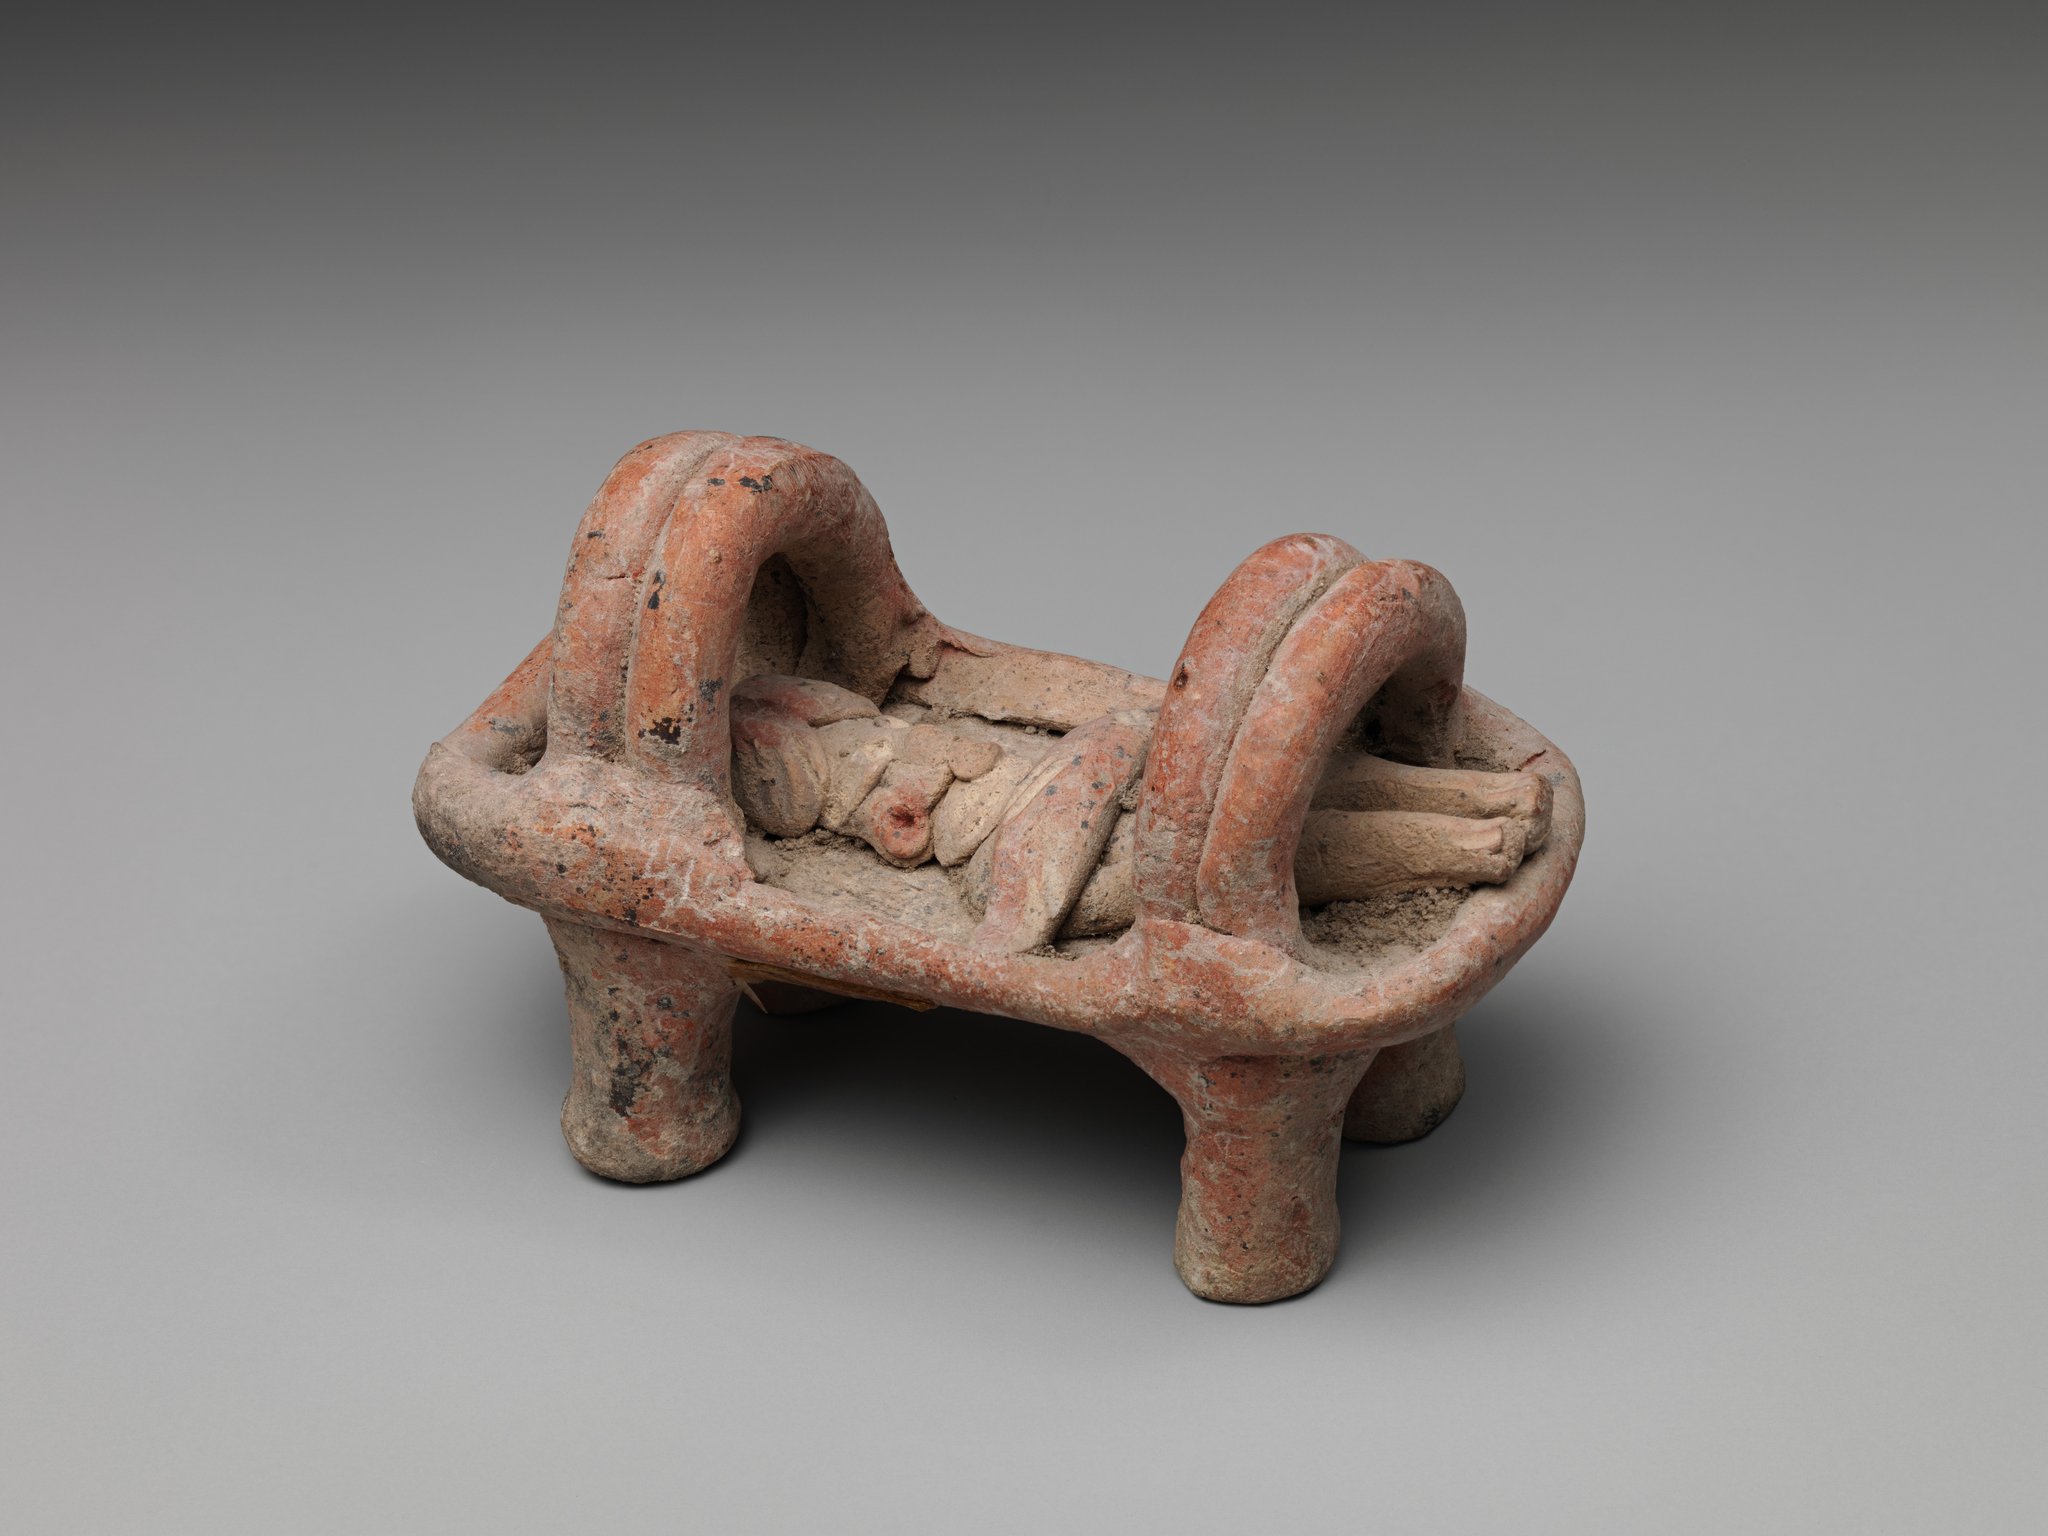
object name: figure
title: Bed Figure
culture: michoacan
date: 300 BCE-400 CE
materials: ceramic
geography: mexico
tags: human figures,beds